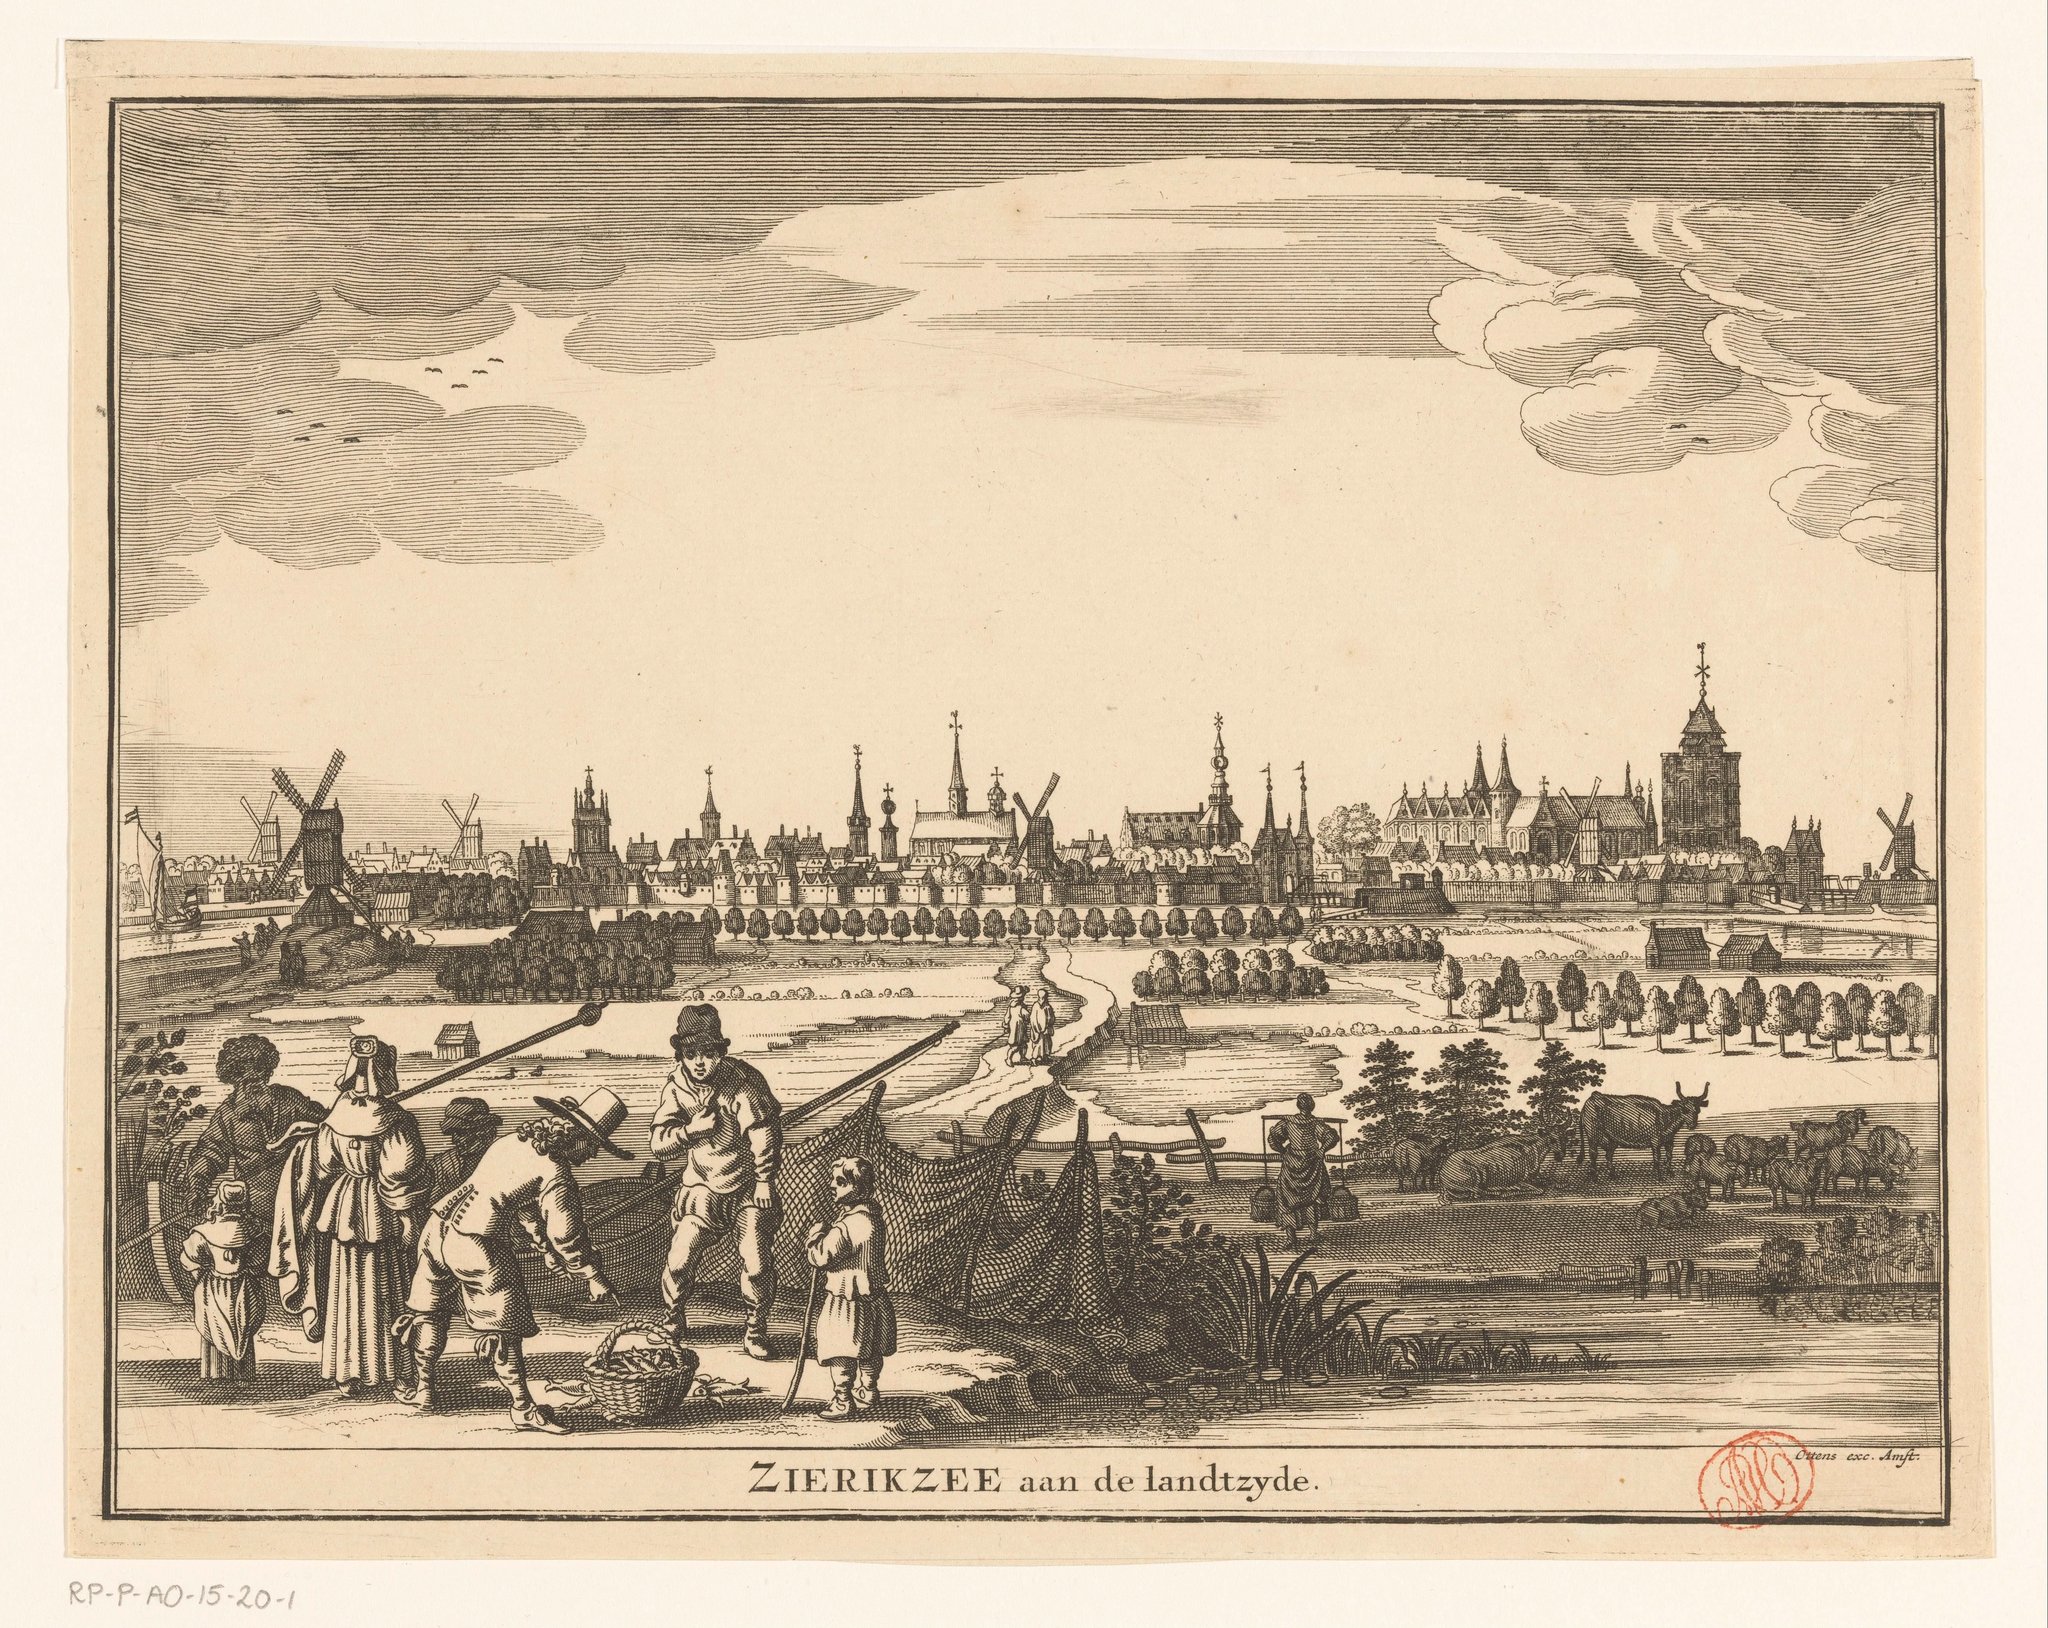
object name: print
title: Gezicht op Zierikzee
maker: pieter hendricksz. schut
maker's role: print maker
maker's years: 1618-1660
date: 1657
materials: paper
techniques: engraving, etching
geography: amsterdam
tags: church (exterior), windmill, prospect of city, town panorama, silhouette of city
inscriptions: collector's mark: Lugt 195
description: Prent ook gebruikt in: Speculum Zelandiae dat is een beschryvinge ofte afbeelding der steden, ambachts-heerlijckheden, dorpen castelen, ridderlijcke hofsteden, huysen en gebouwen gelegen inde eylanden en de graeflijckheyt van Zeelandt. Amsterdam: weduwe Ottens en Zoonen, s.a. [1719-1725]. Eerdere staat/staten van prent is/zijn gebruikt in eerdere uitgaven van 'Speculum Zelandiae' en in andere publicaties uitgegeven door Zacharias Roman en Nicolaes Visscher (I). De eerste publicatie waarin de eerste staat van de huidige prent voorkomt dateert uit 1657. Verwarring rondom de datering kan ontstaan door het feit de prenten uit 'Speculum Zelandiae' ook voorkomen in eerder uitgegeven publicaties, waar ze later in zijn ingebonden. Zo komen prenten uitgegeven door Roman/Visscher voor in sommige exemplaren van: Boxhorn, Marcus Zuerius van. Chroniick van Zeelandt (…). 2 delen. Middelburg: Zacharias Roman, 1644. De door weduwe (Joachim) Ottens en Zoonen uitgegeven prenten zijn later ingebonden in sommige exemplaren van: Smallegange, Mattheus. Nieuwe Cronyk van Zeeland (…). Middelburg en Amsterdam: Johannes Meertens en Abraham van Someren, 1696.